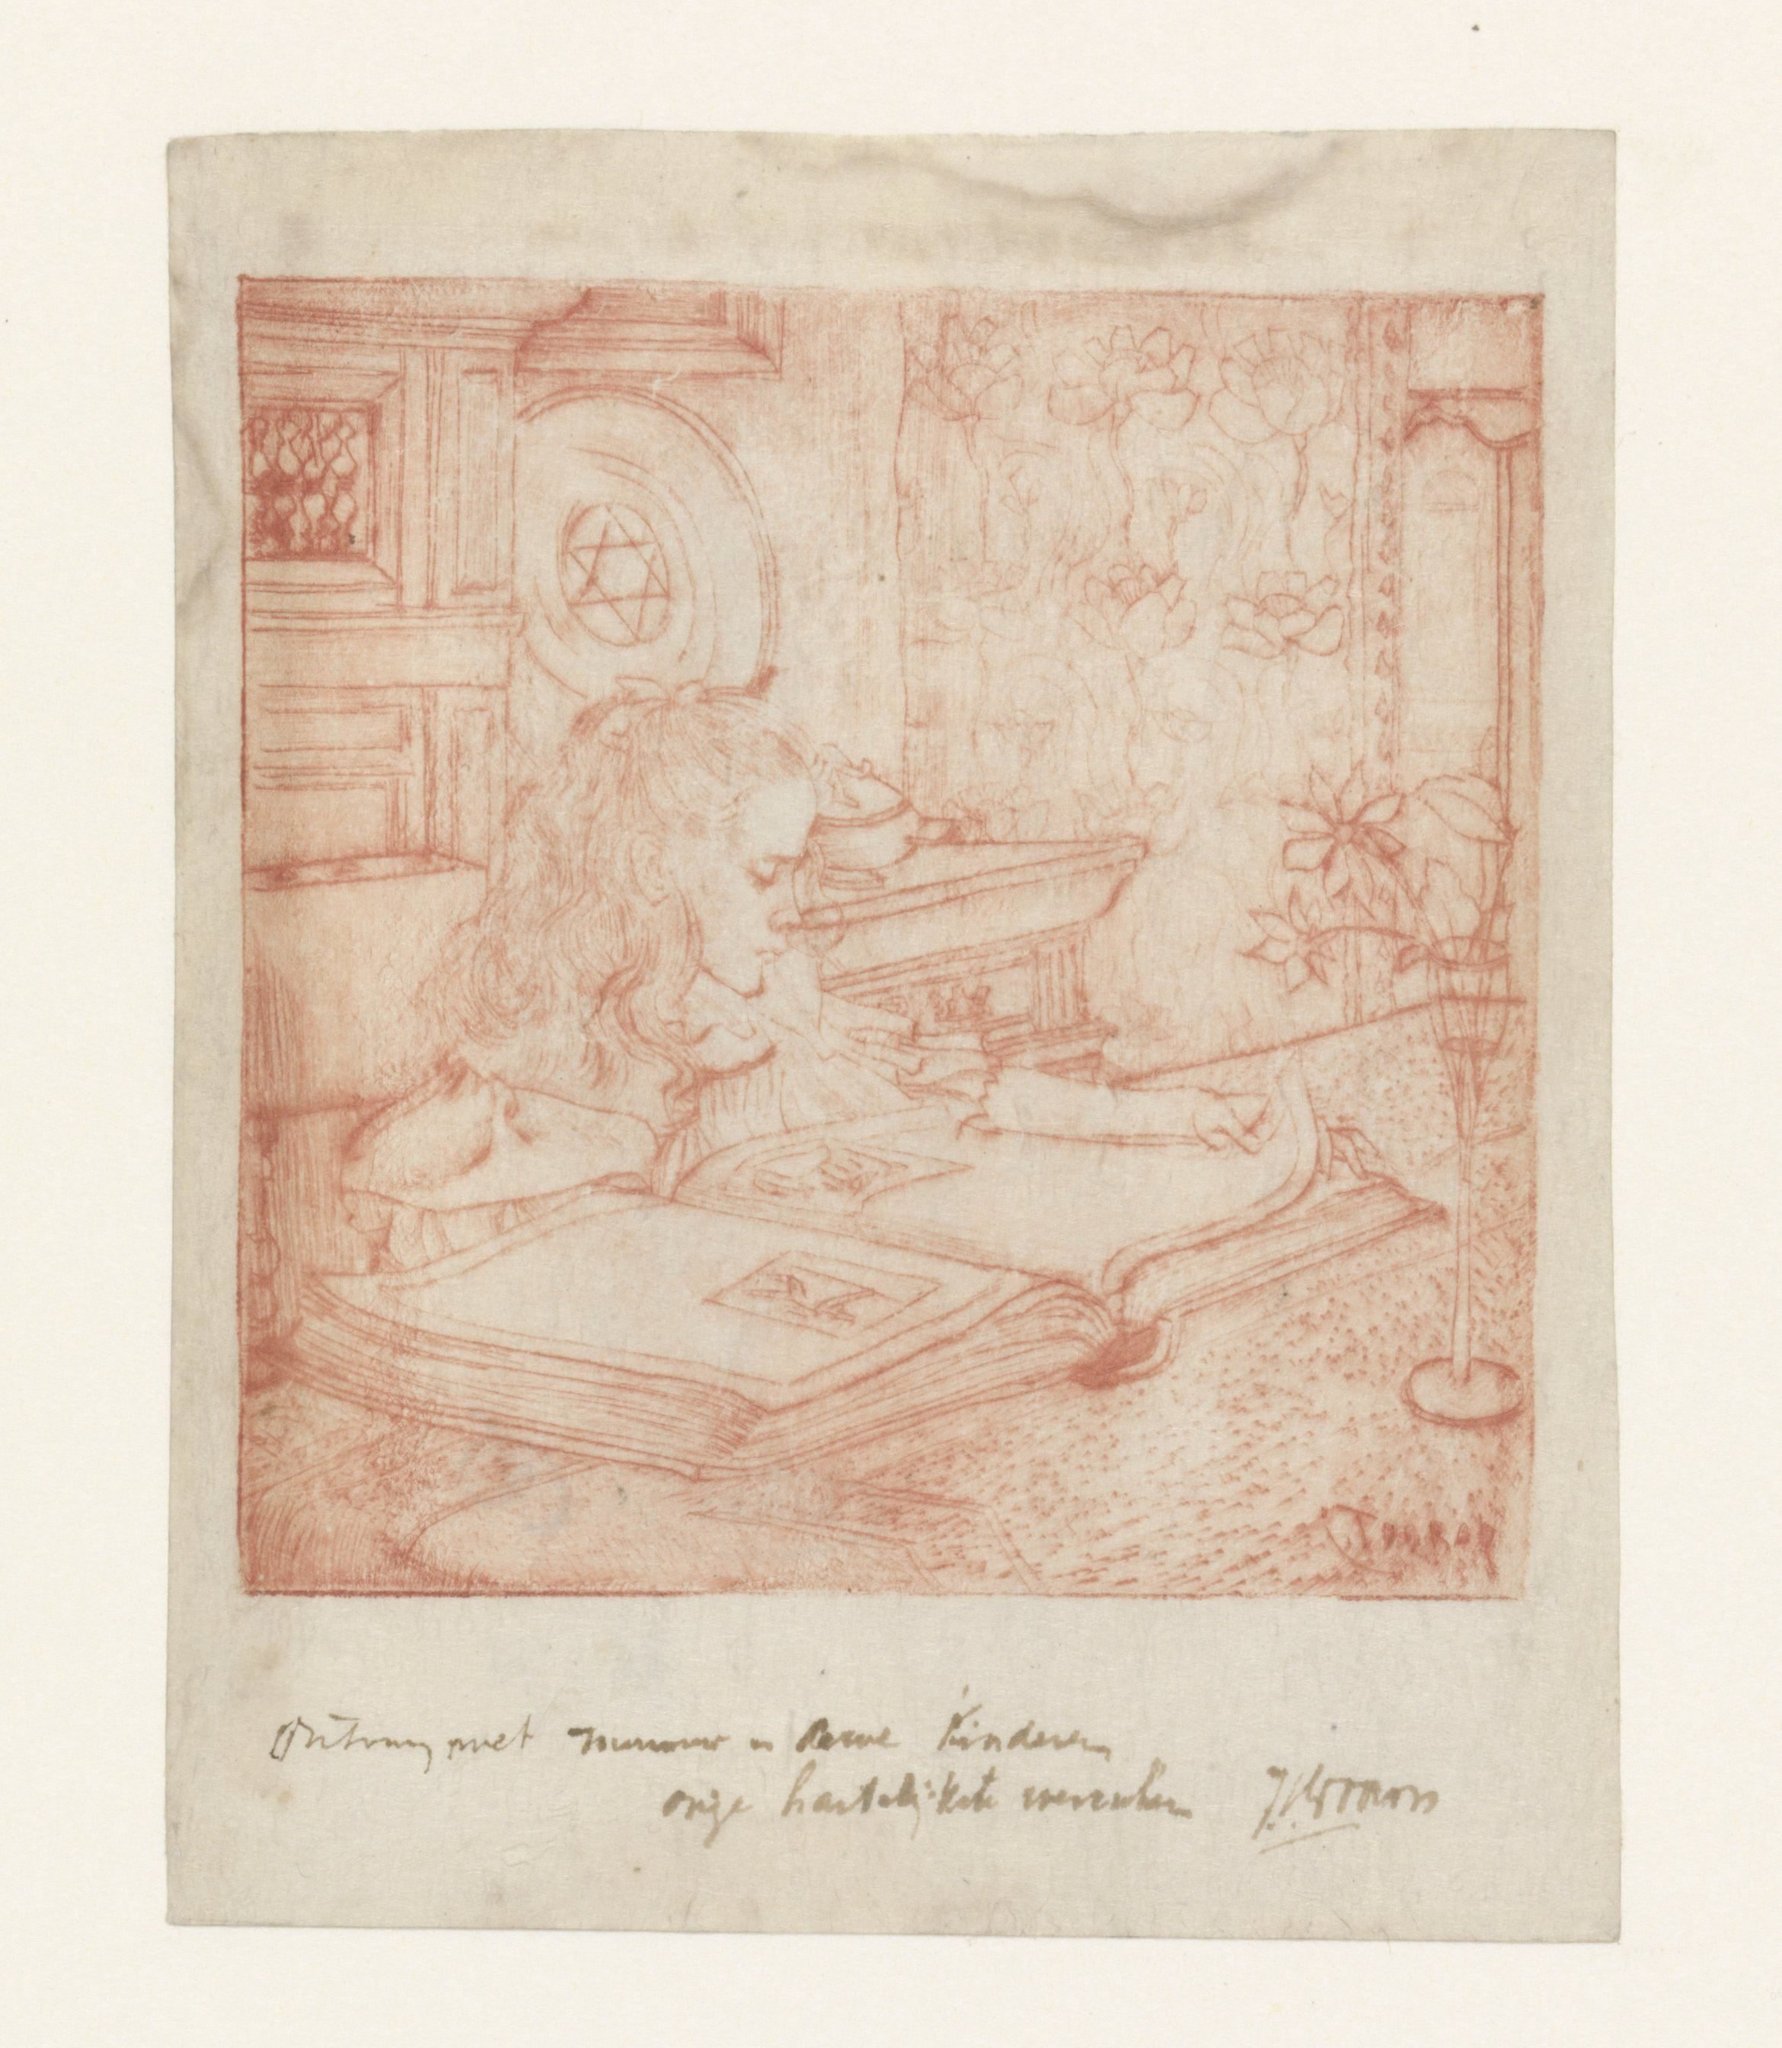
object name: print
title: Portret van Charley Toorop, kijkend in een platenboek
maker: jan toorop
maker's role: draughtsman, painter, print maker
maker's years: 1858-1928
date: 1898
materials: paper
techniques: drypoint, intaglio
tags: print maker, draughtsman, charley toorop, reading, historical persons, girl (child between toddler and youth)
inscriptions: inscription: ‘Ontvang met […] lieve kinderen/ onze hartelijkste wenschen’, collector's mark: ‘KL’, collector's mark: Lugt 2228